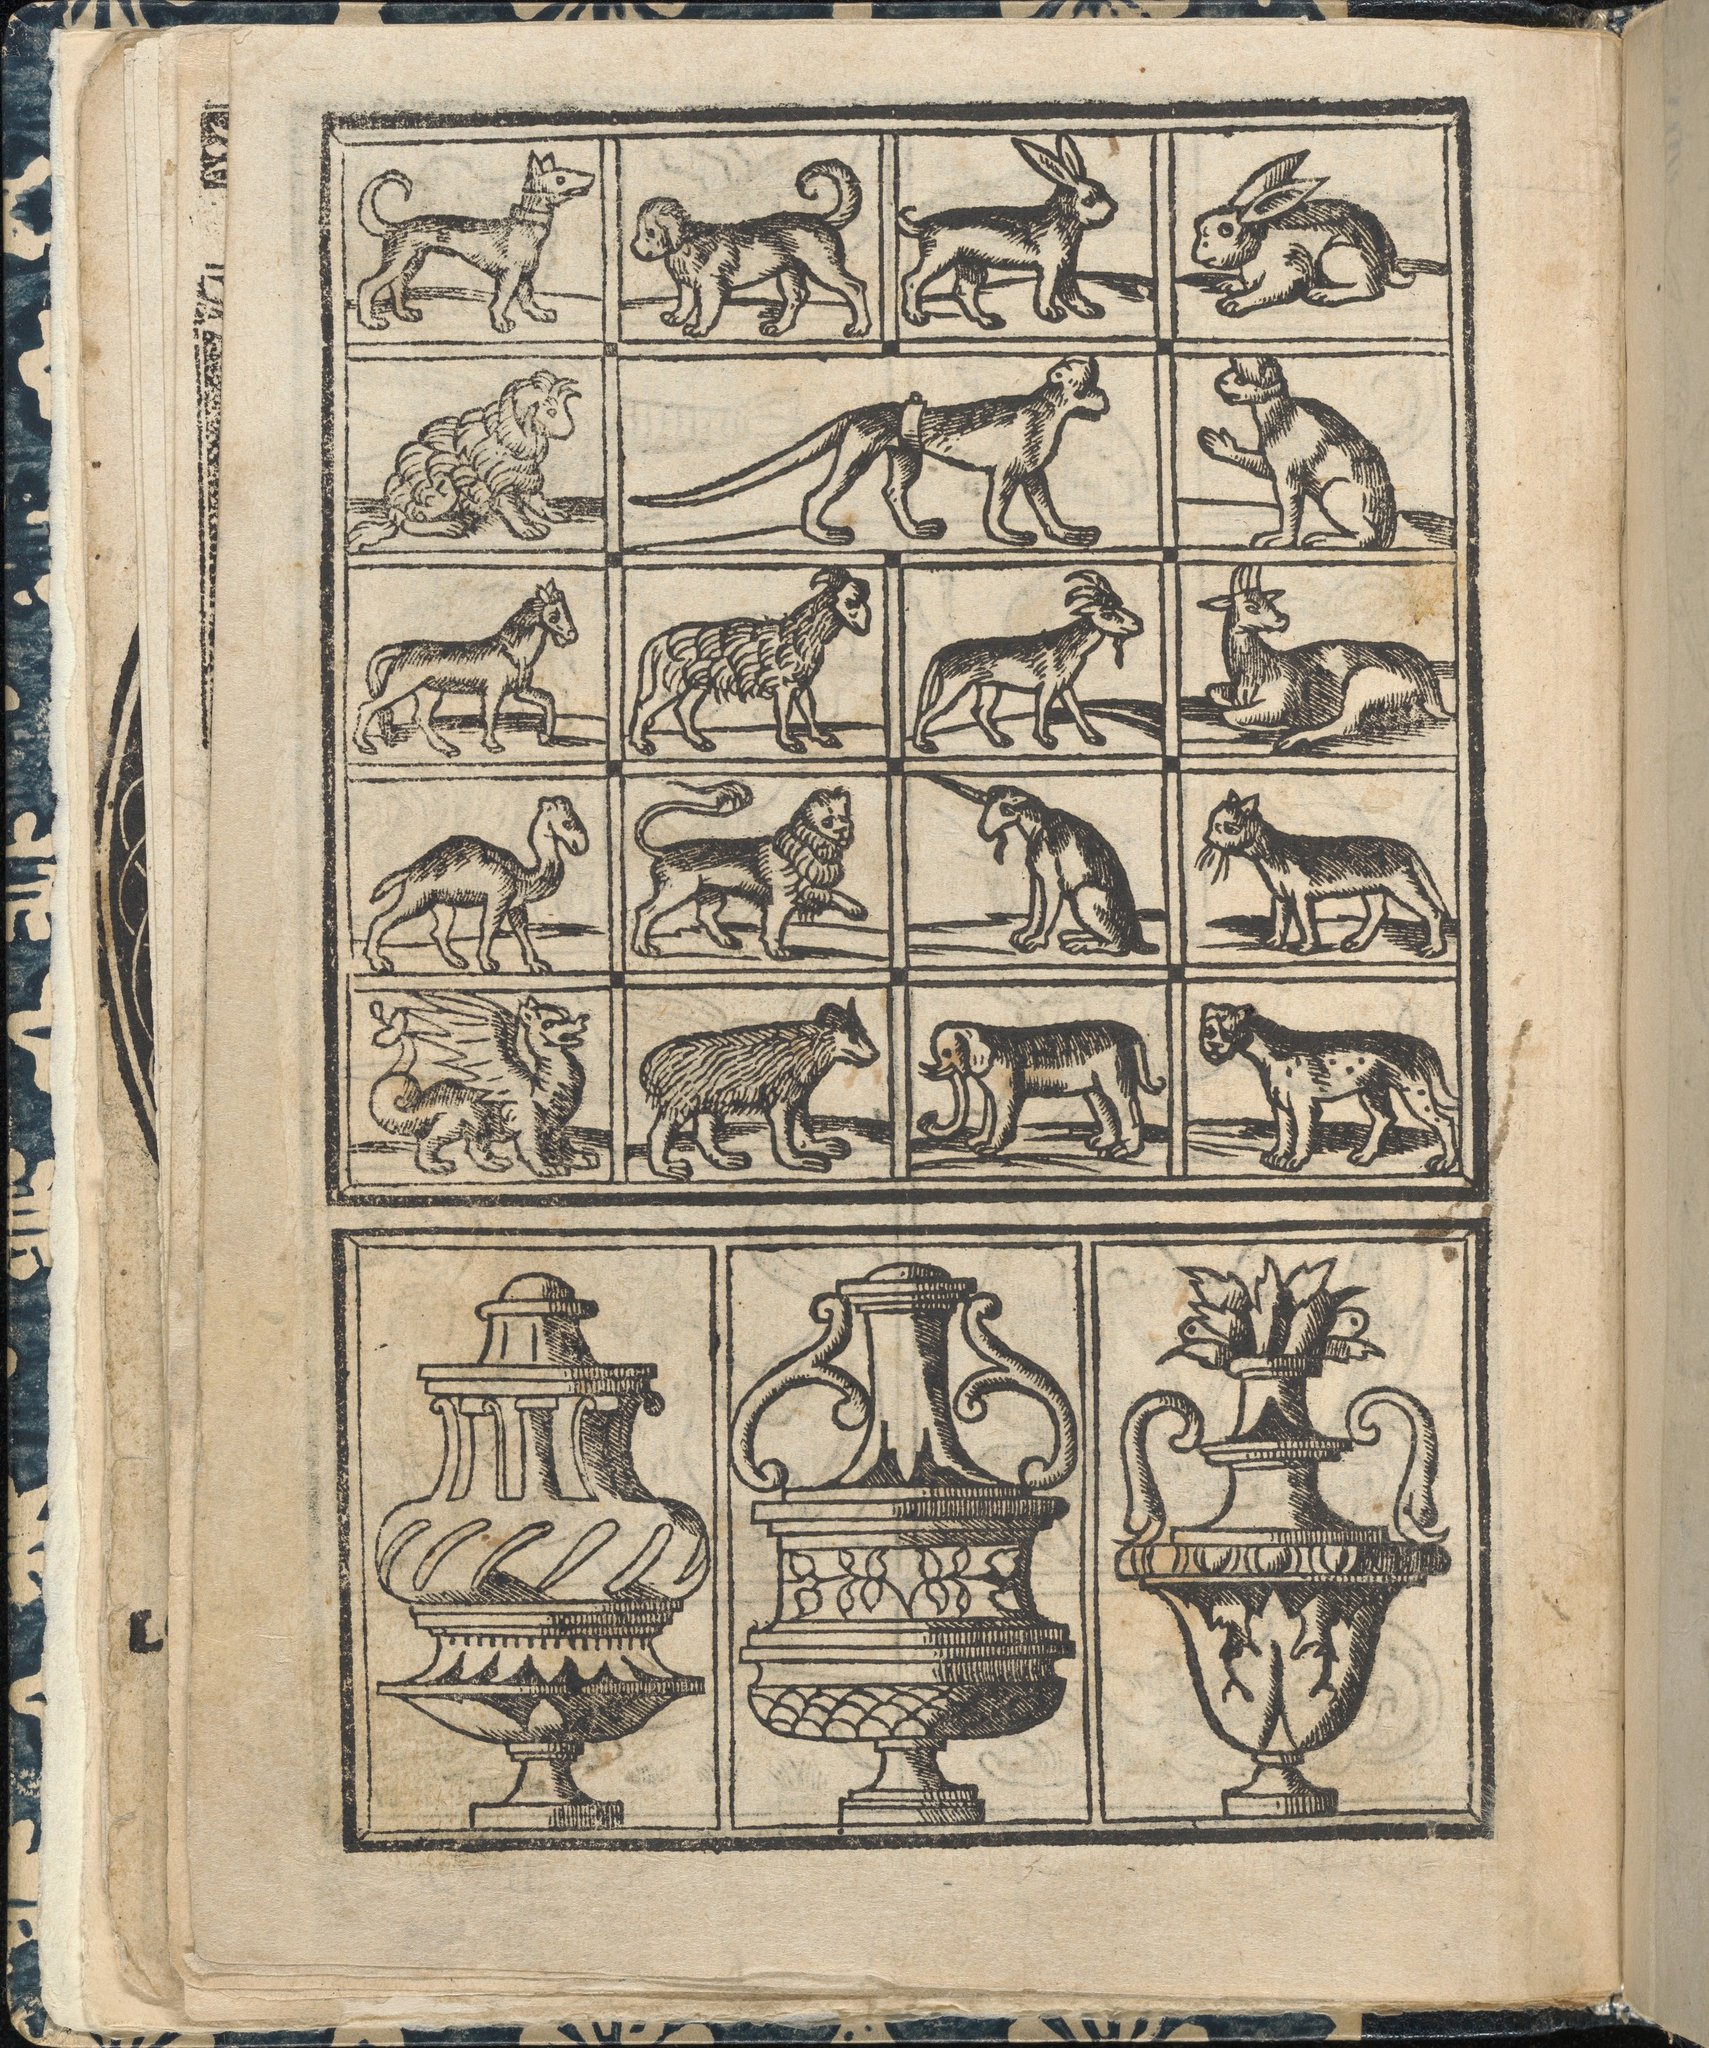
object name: book print ornament architecture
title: Essempio di recammi, page 11 (verso)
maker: giovanni antonio tagliente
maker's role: author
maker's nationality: italian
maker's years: 1465-1528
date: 1530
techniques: woodcut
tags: dragons,camels,cats,dogs,horses,rabbits,rams,urns